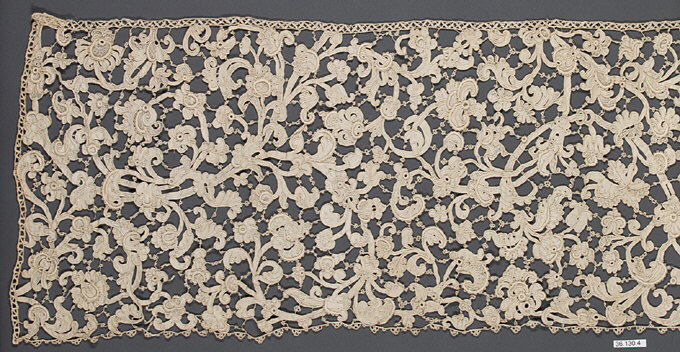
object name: flounce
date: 1601-1700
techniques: lace